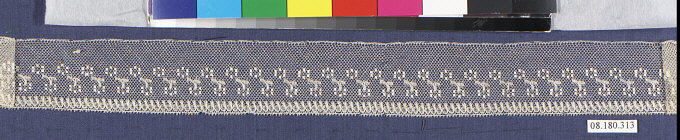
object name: fragment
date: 1801-1900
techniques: lace